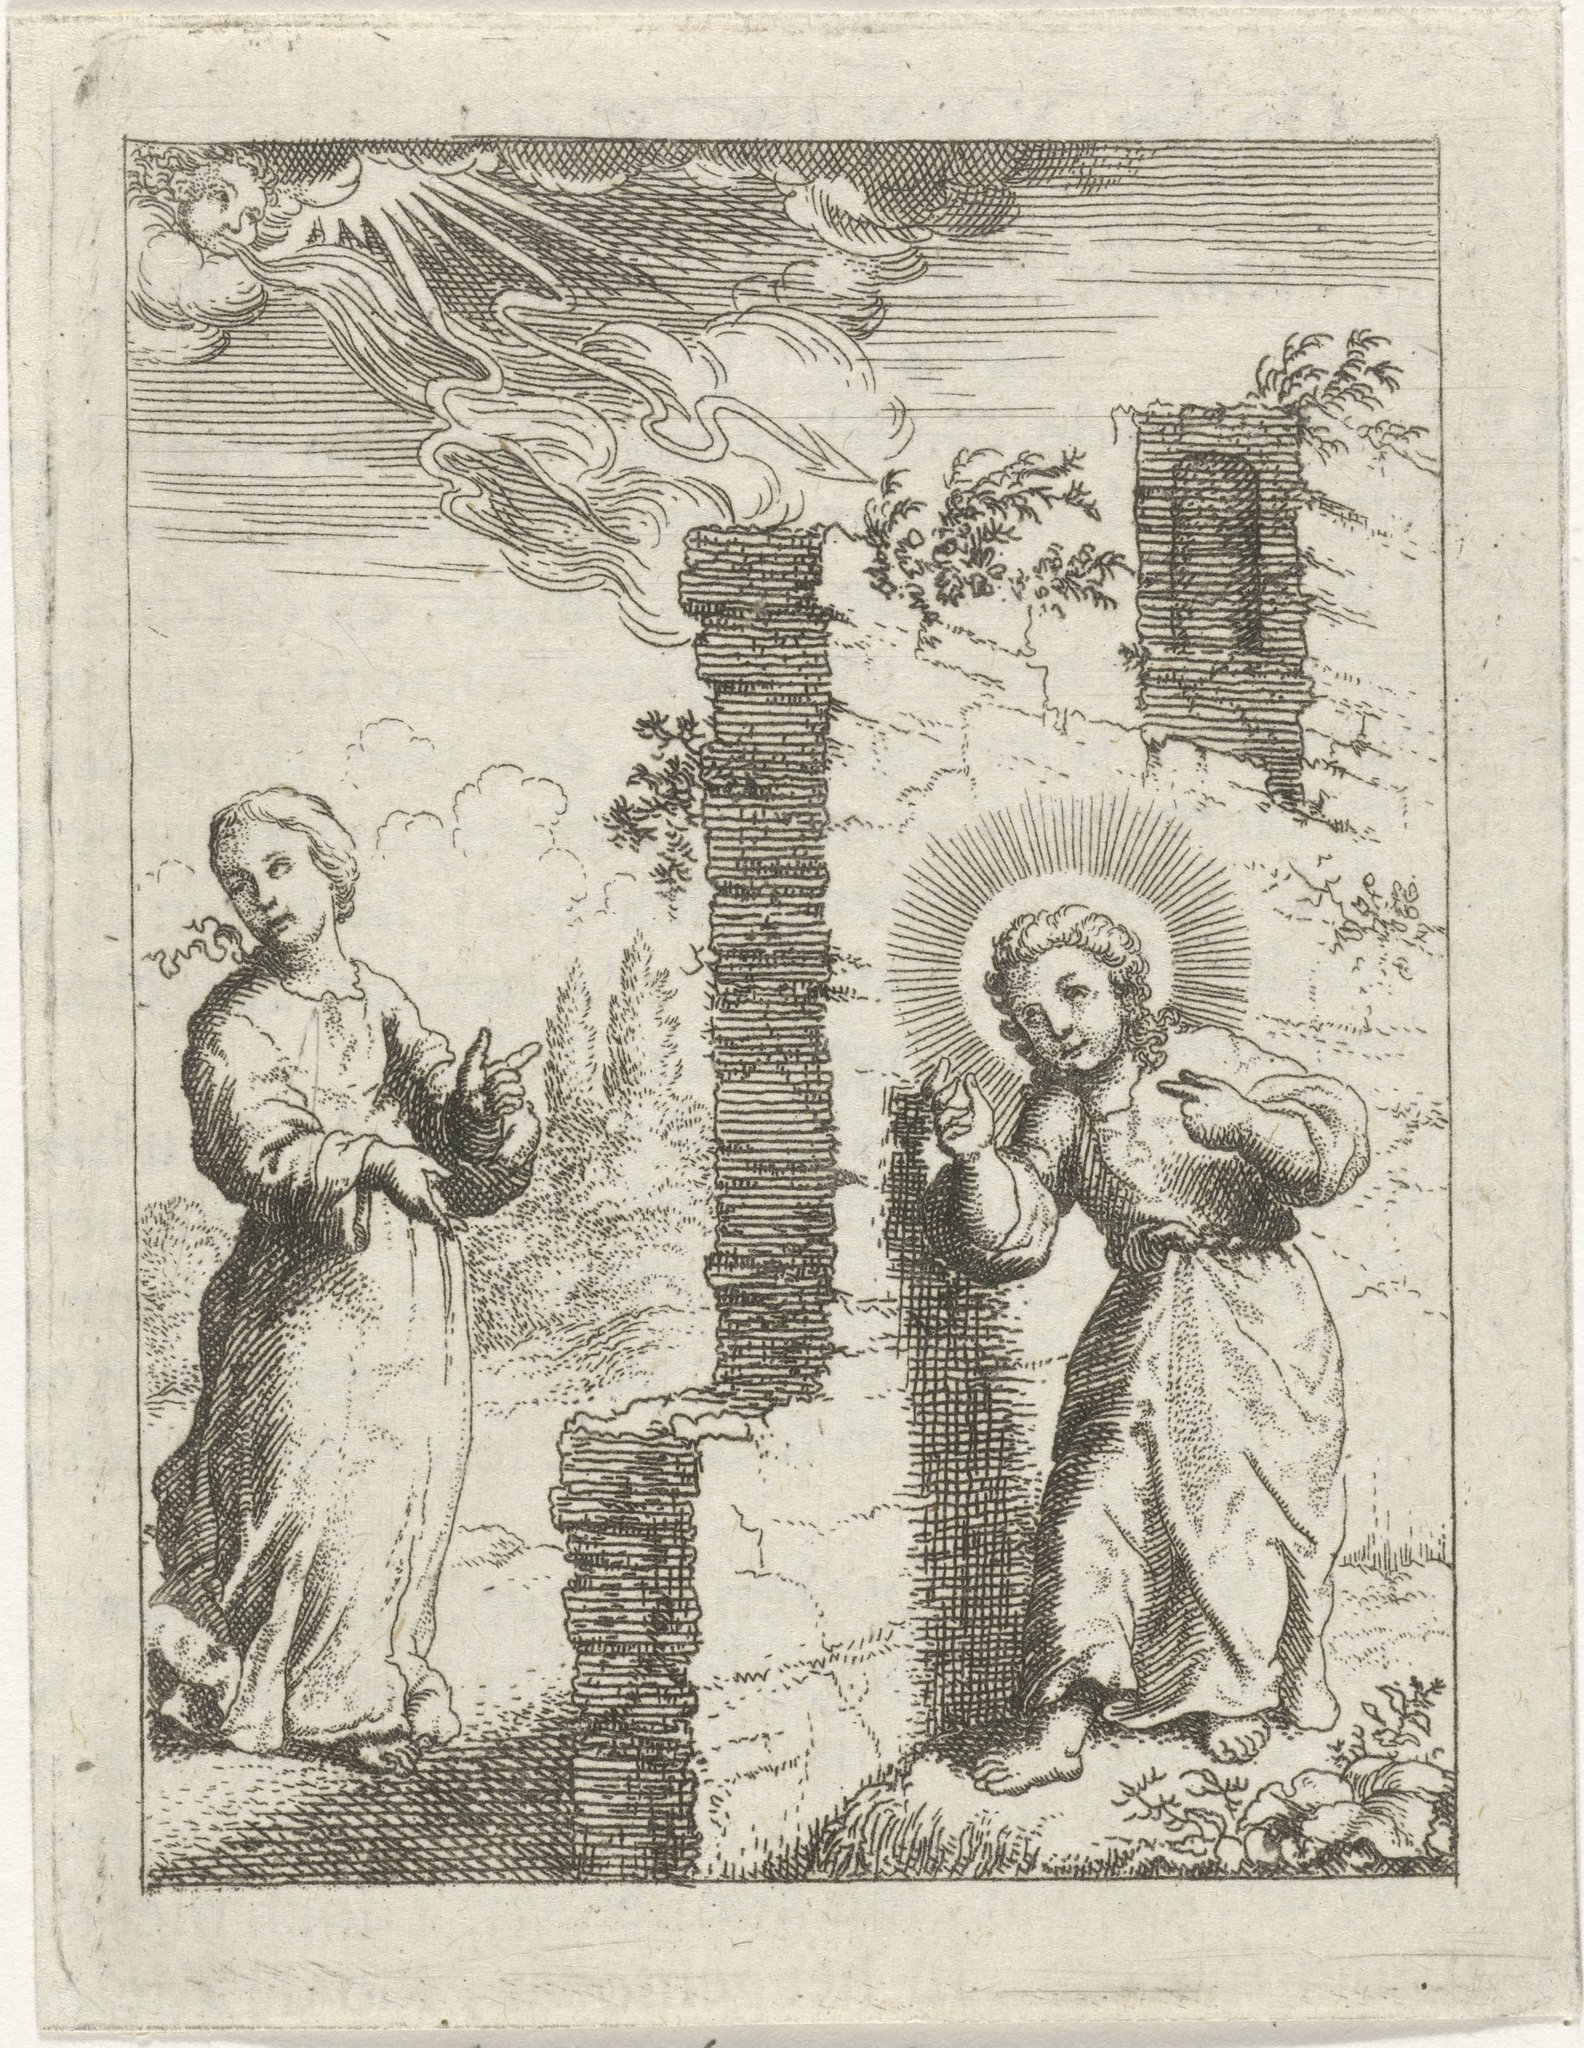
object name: print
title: Christus klopt op een muur waarachter de gepersonifieerde ziel staat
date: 1678-1687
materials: paper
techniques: etching, letterpress printing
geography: amsterdam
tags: the soul, christ and the soul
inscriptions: collector's mark: Lugt 2228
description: Illustratie uit: Luyken, Jan. Jezus en de Ziel, 3 delen. Amsterdam: Pieter Arentsz II, 1678-1687. Tussen 1678-1744 verschenen van dit emblemataboek 10 edities.